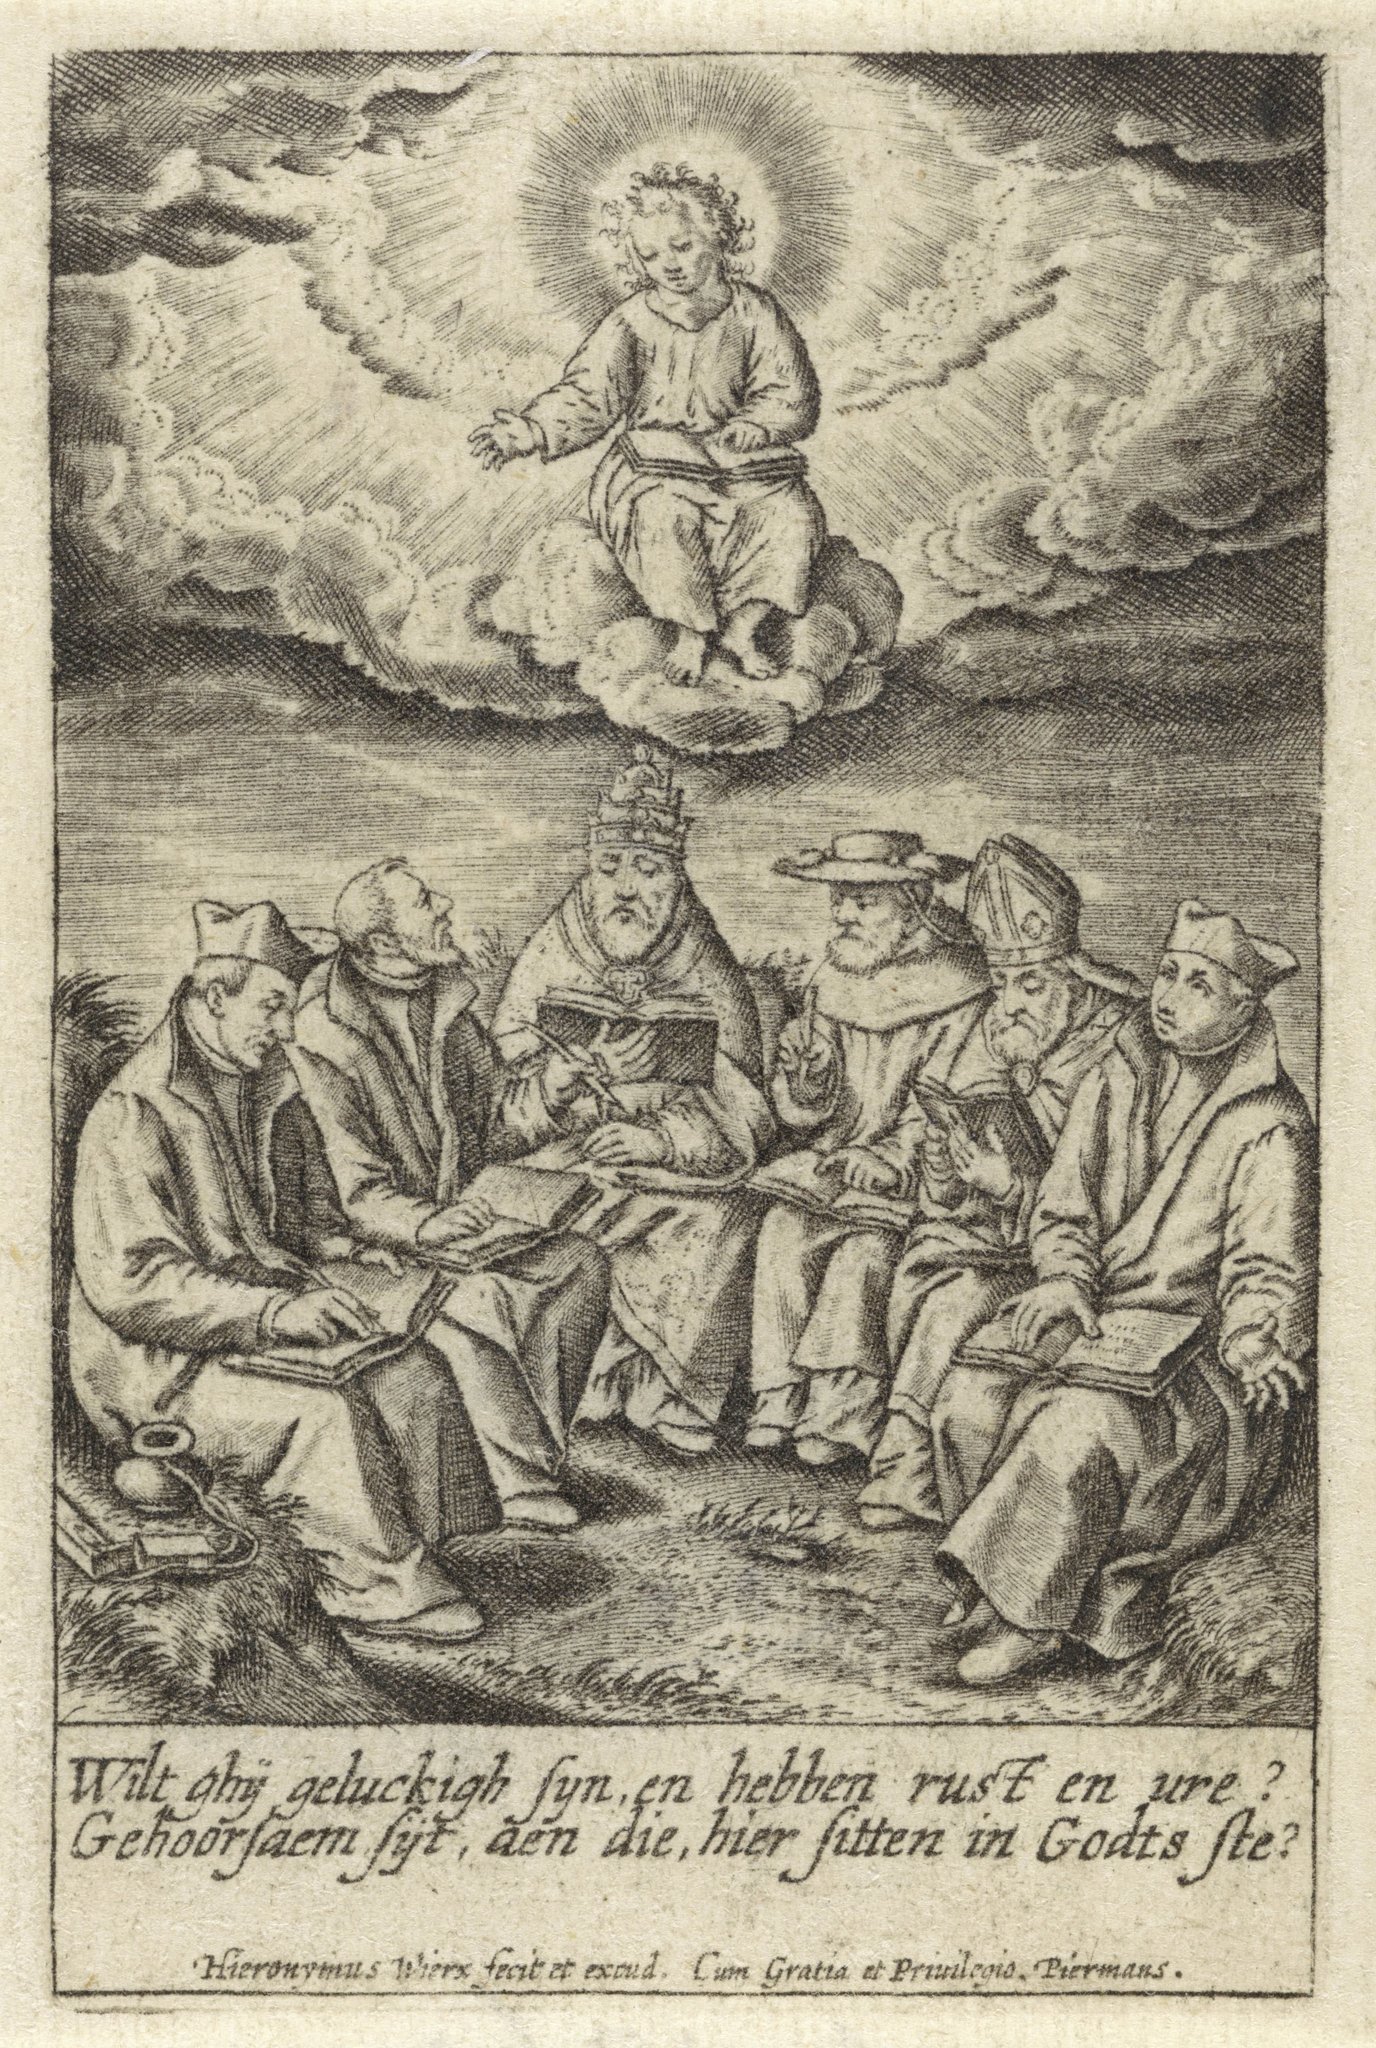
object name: print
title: Aanbidding van het Christuskind door geestelijken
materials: paper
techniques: engraving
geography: antwerp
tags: christ-child (with attributes), organization, functionaries and dignitaries in roman catholic church; clergy in general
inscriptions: collector's mark: Lugt 2228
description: Zes geestelijken aanbidden het Christuskind dat hen zegent vanaf een wolk. Het gezelschap bestaat uit een paus, een kardinaal, een bisschop en drie Jezuïeten. In de marge een tweeregelig onderschrift in het Nederlands.